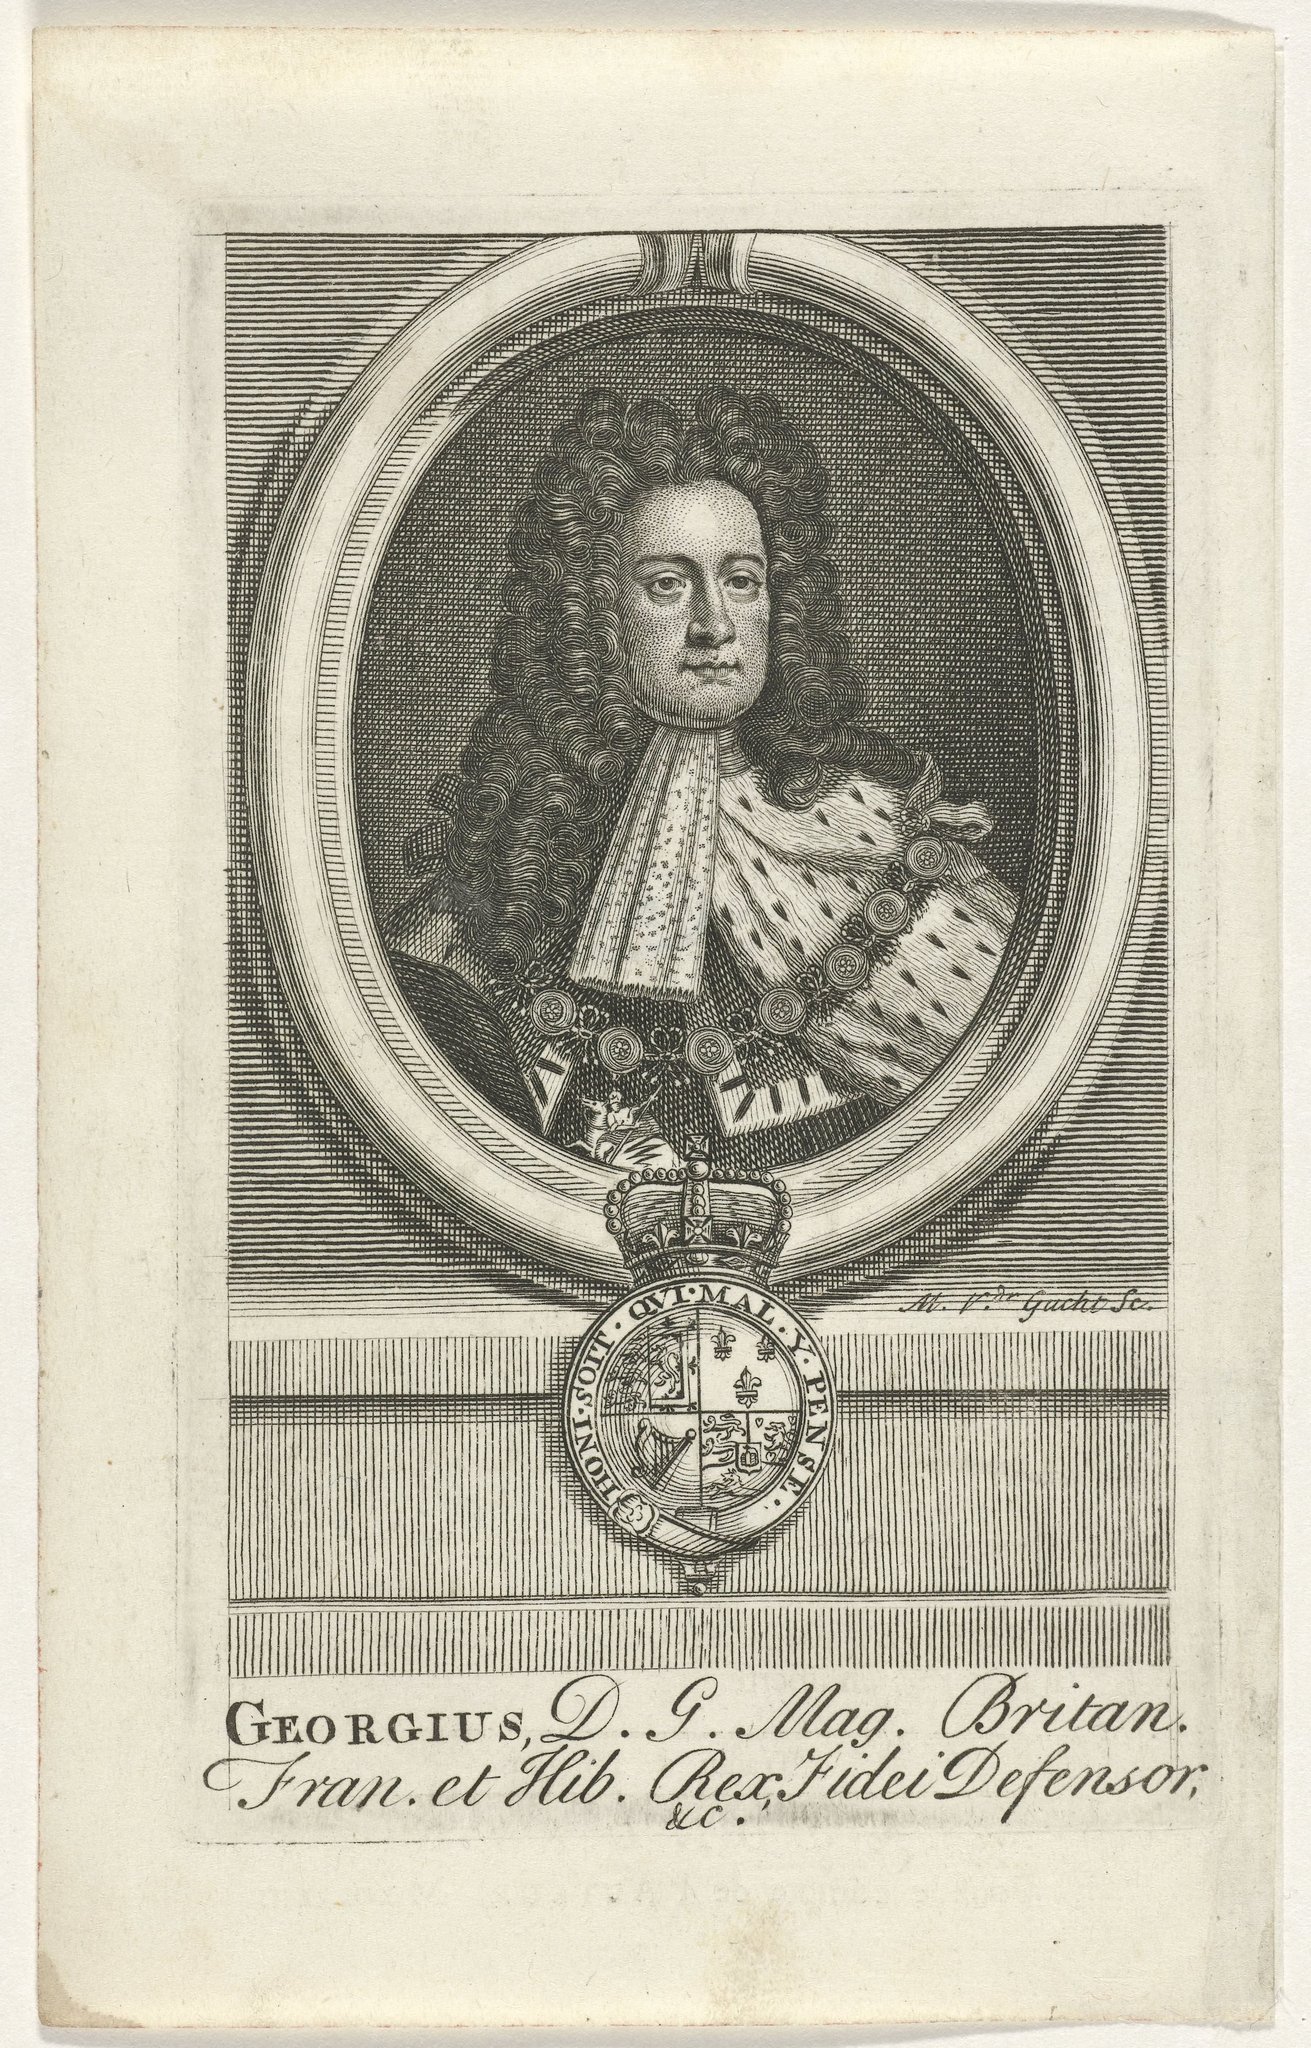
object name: print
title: Portret van George I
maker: michiel van der gucht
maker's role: print maker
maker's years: 1660-1725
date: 1670-1725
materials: paper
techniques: engraving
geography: antwerp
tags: george i (koning van groot-brittannië en ierland)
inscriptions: collector's mark: Lugt 2228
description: Portret van George I, koning van Groot-Brittannië, Frankrijk en Ierland, gehuld in kroningsmantel. Het portret is gevat in een ovale omlijsting. Onderaan in het ovaal een ruiter met lans. Onder het portret een bekroond wapenschild met een Latijnse spreuk. In de marge de naam en functie van de geportretteerde.